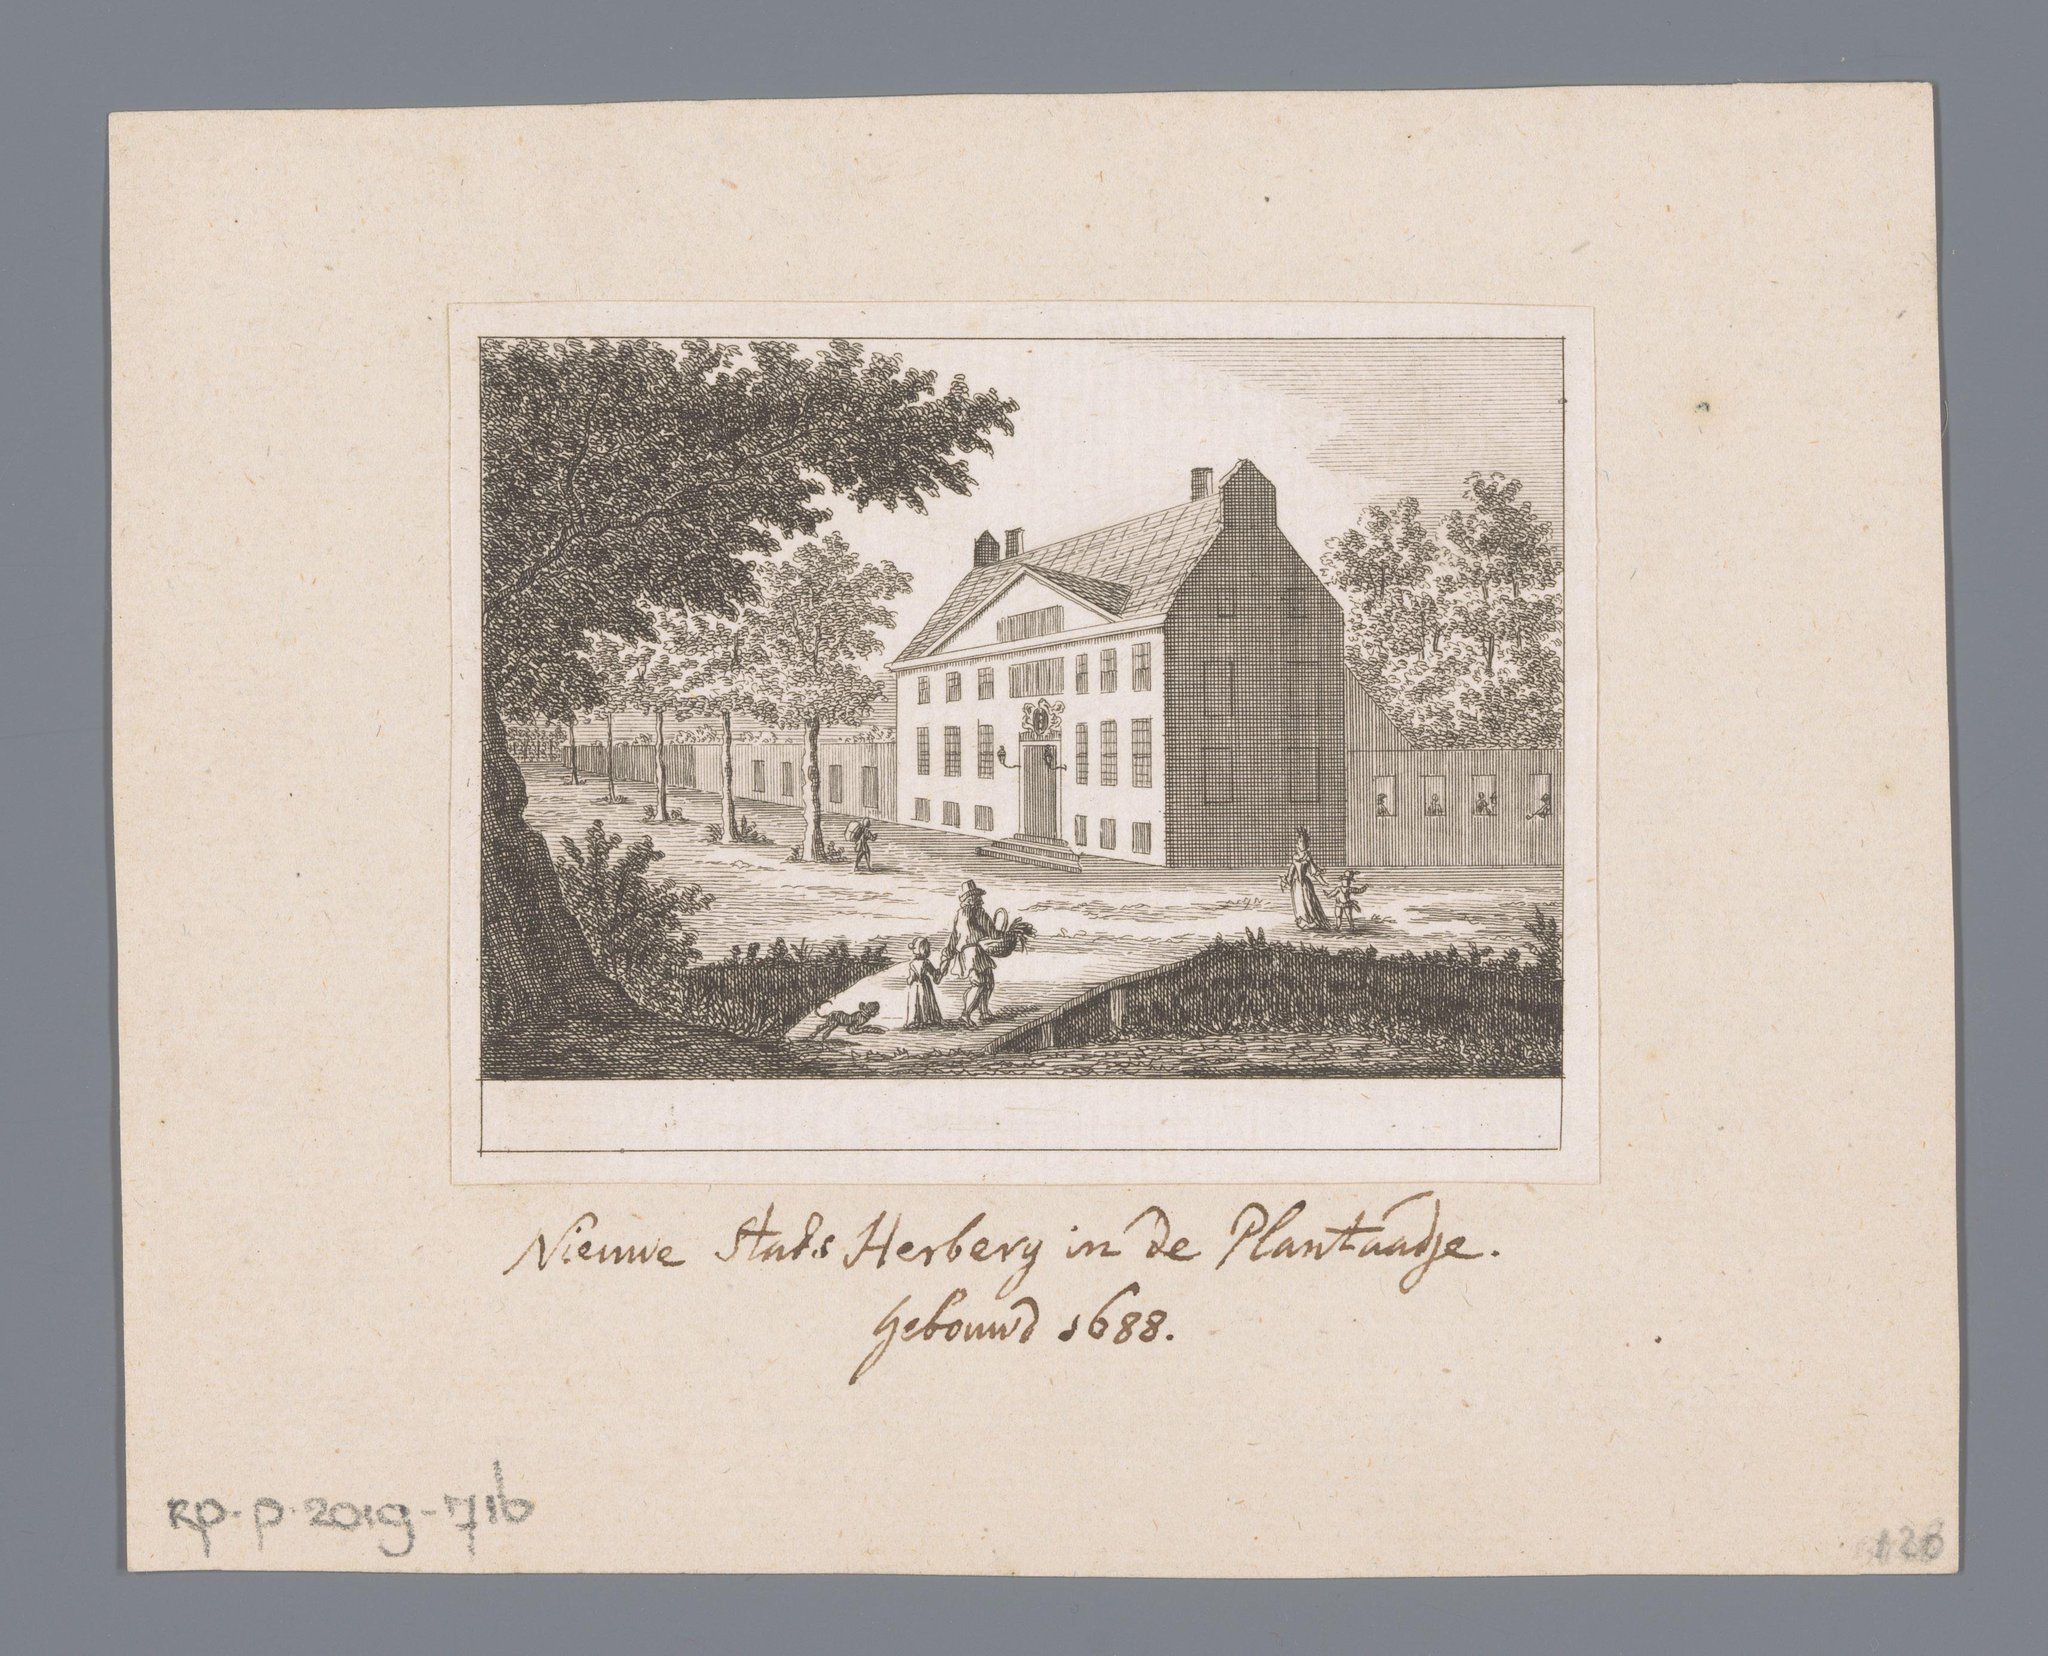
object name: print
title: Gezicht op de Nieuwe Stadsherberg in de Plantage in Amsterdam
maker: Anonymous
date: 1686-1800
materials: paper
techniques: engraving, etching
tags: hotel, hostelry, inn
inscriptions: annotation: ‘Nieuwe Stads Herberg in de Plantaadje. Gebouwd 1688.’